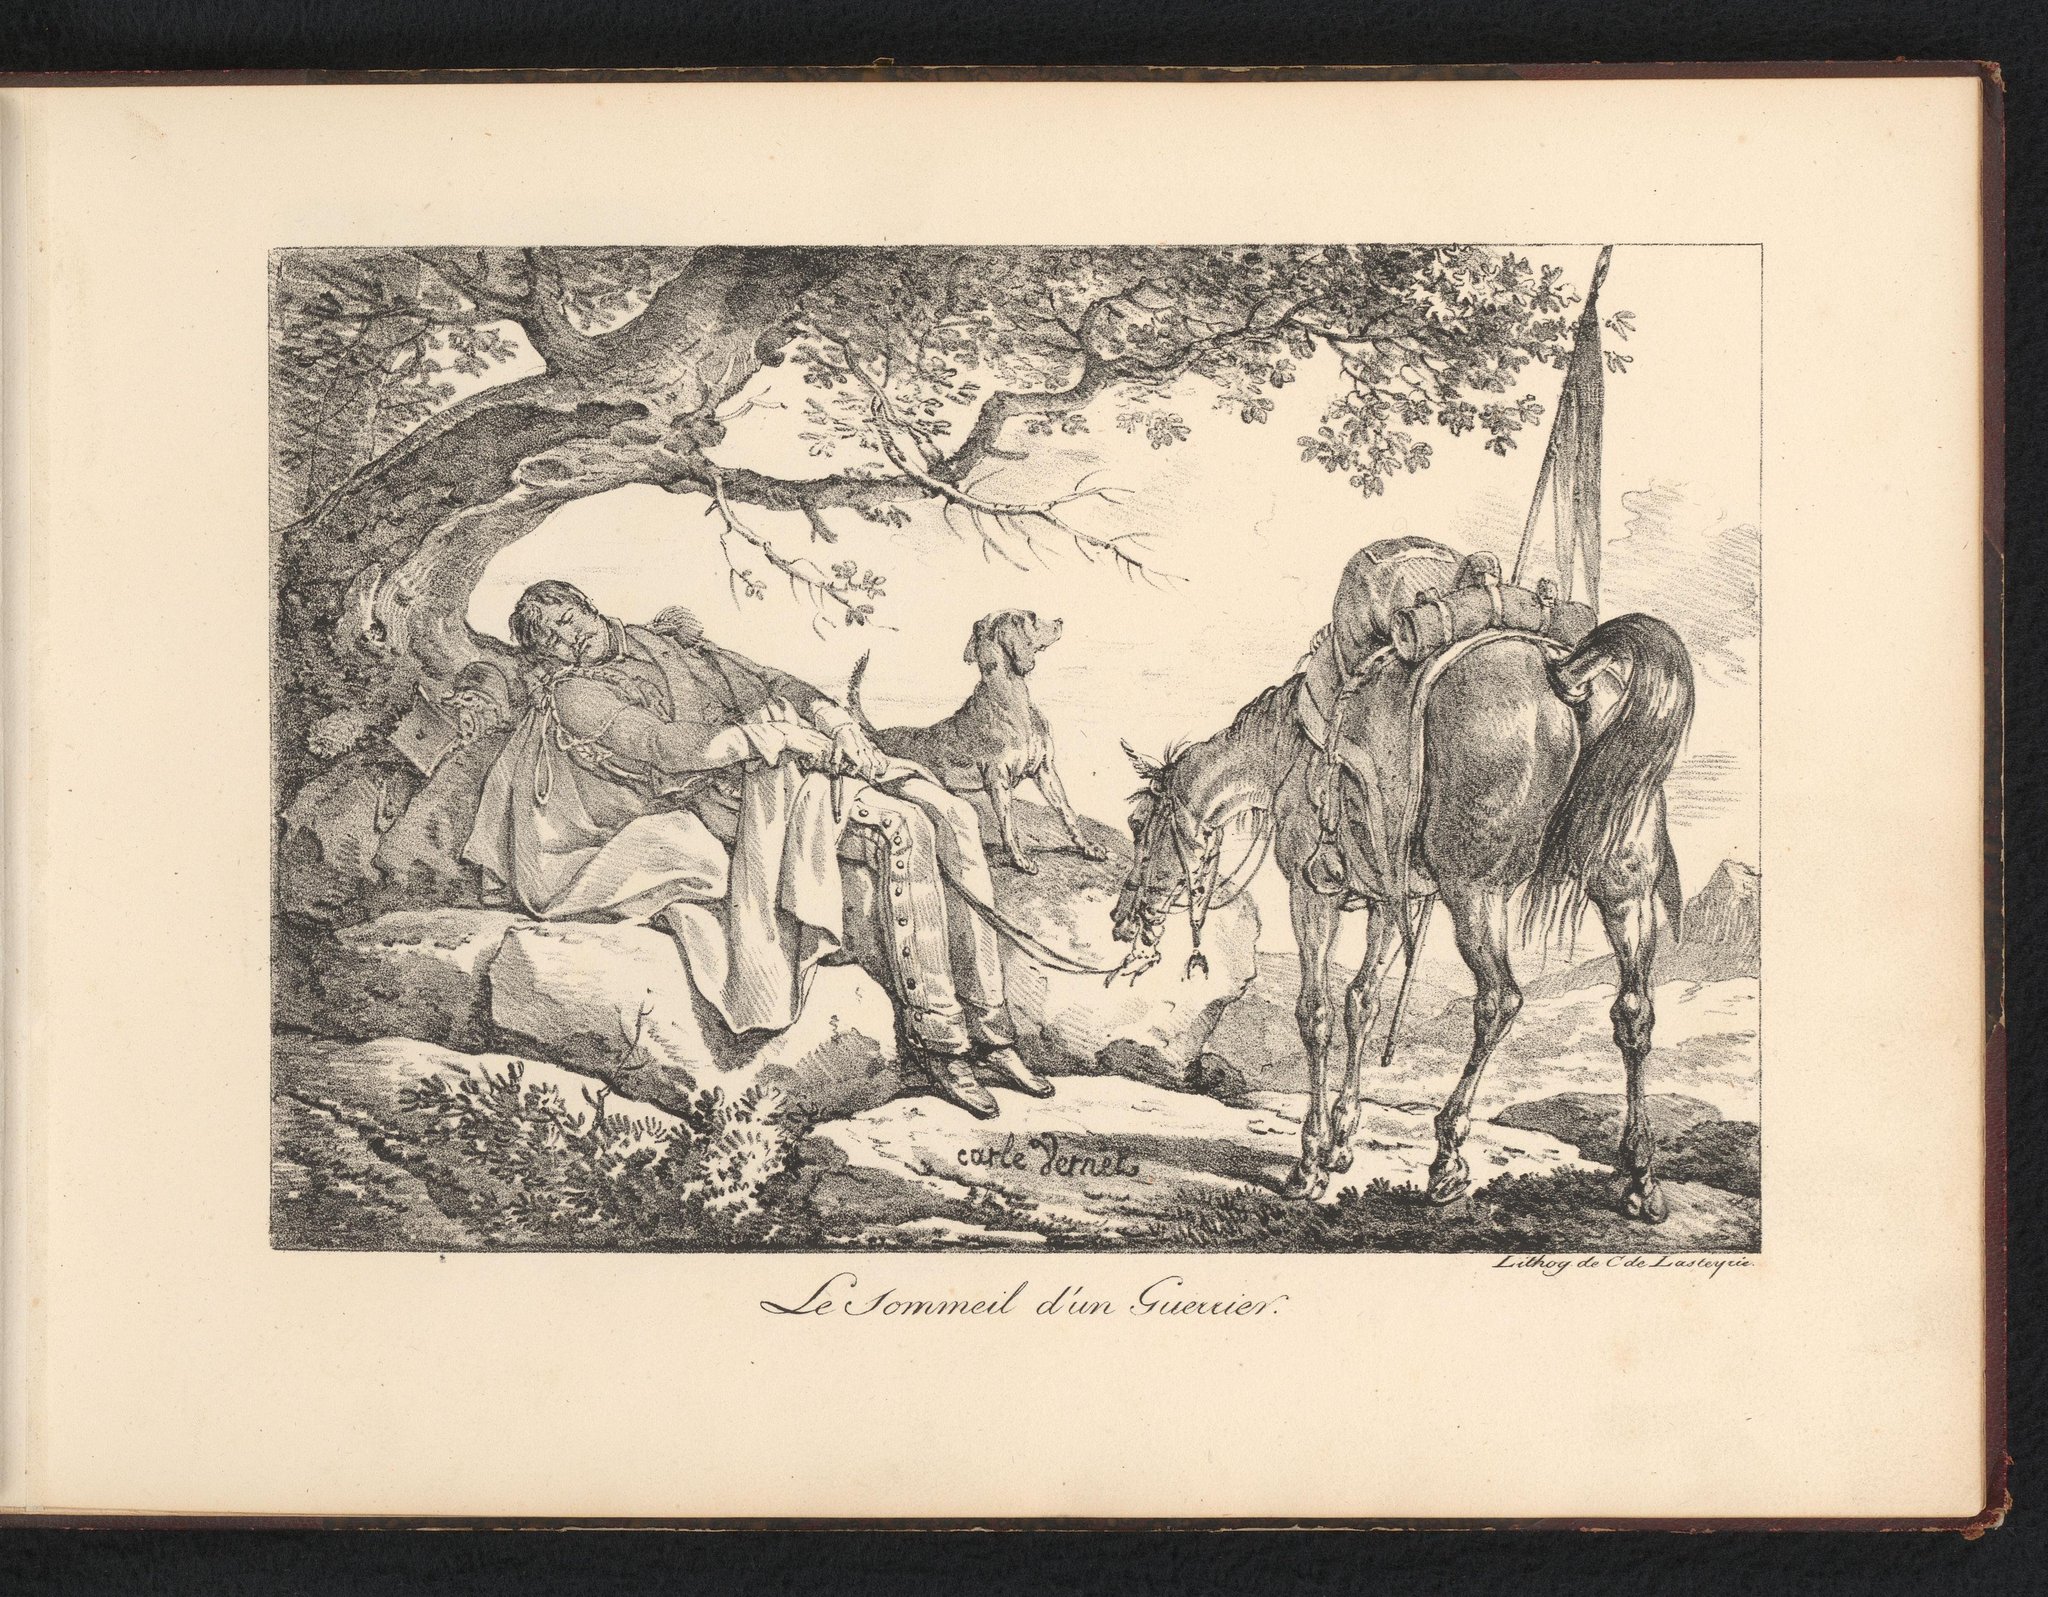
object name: print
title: Slapende soldaat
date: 1817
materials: paper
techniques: lithograph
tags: sleeping on the ground - bb - out of doors, the soldier; the soldier's life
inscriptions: collector's mark: Lugt 2760, collector's mark: Lugt 2228